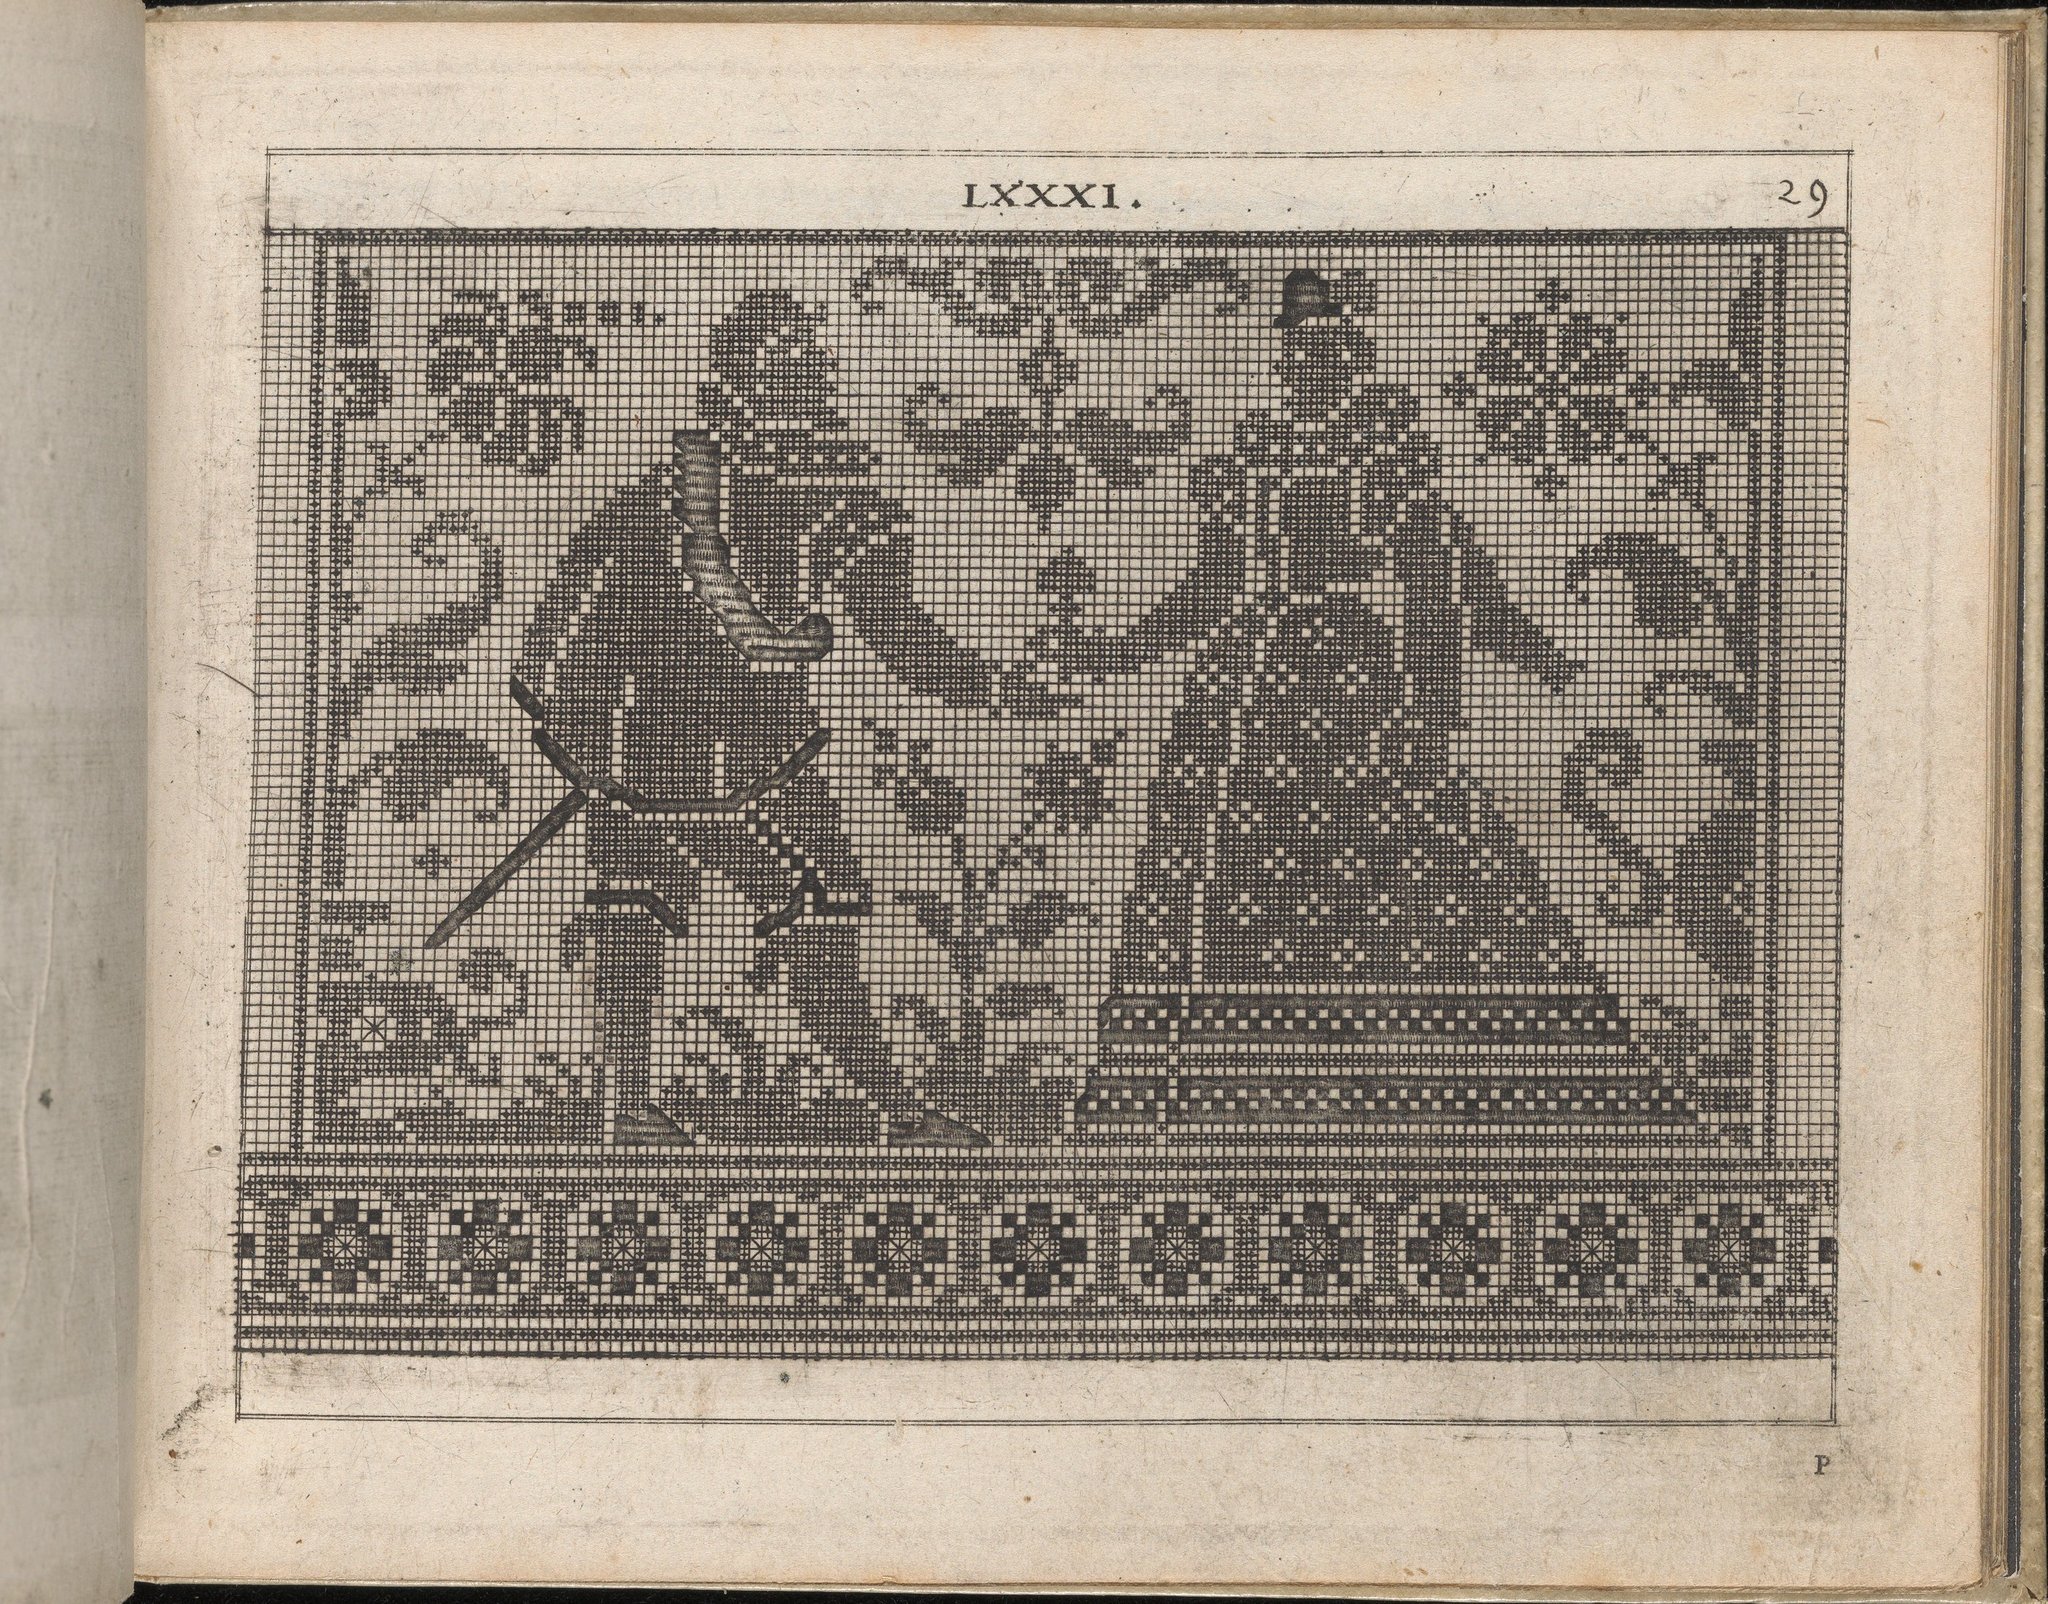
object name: book print ornament architecture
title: Newes Modelbuch in Kupffer (Page 38r)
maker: johann sibmacher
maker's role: artist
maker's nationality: german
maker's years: 1590-1611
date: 1604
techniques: etching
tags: men,women,flowers,plants